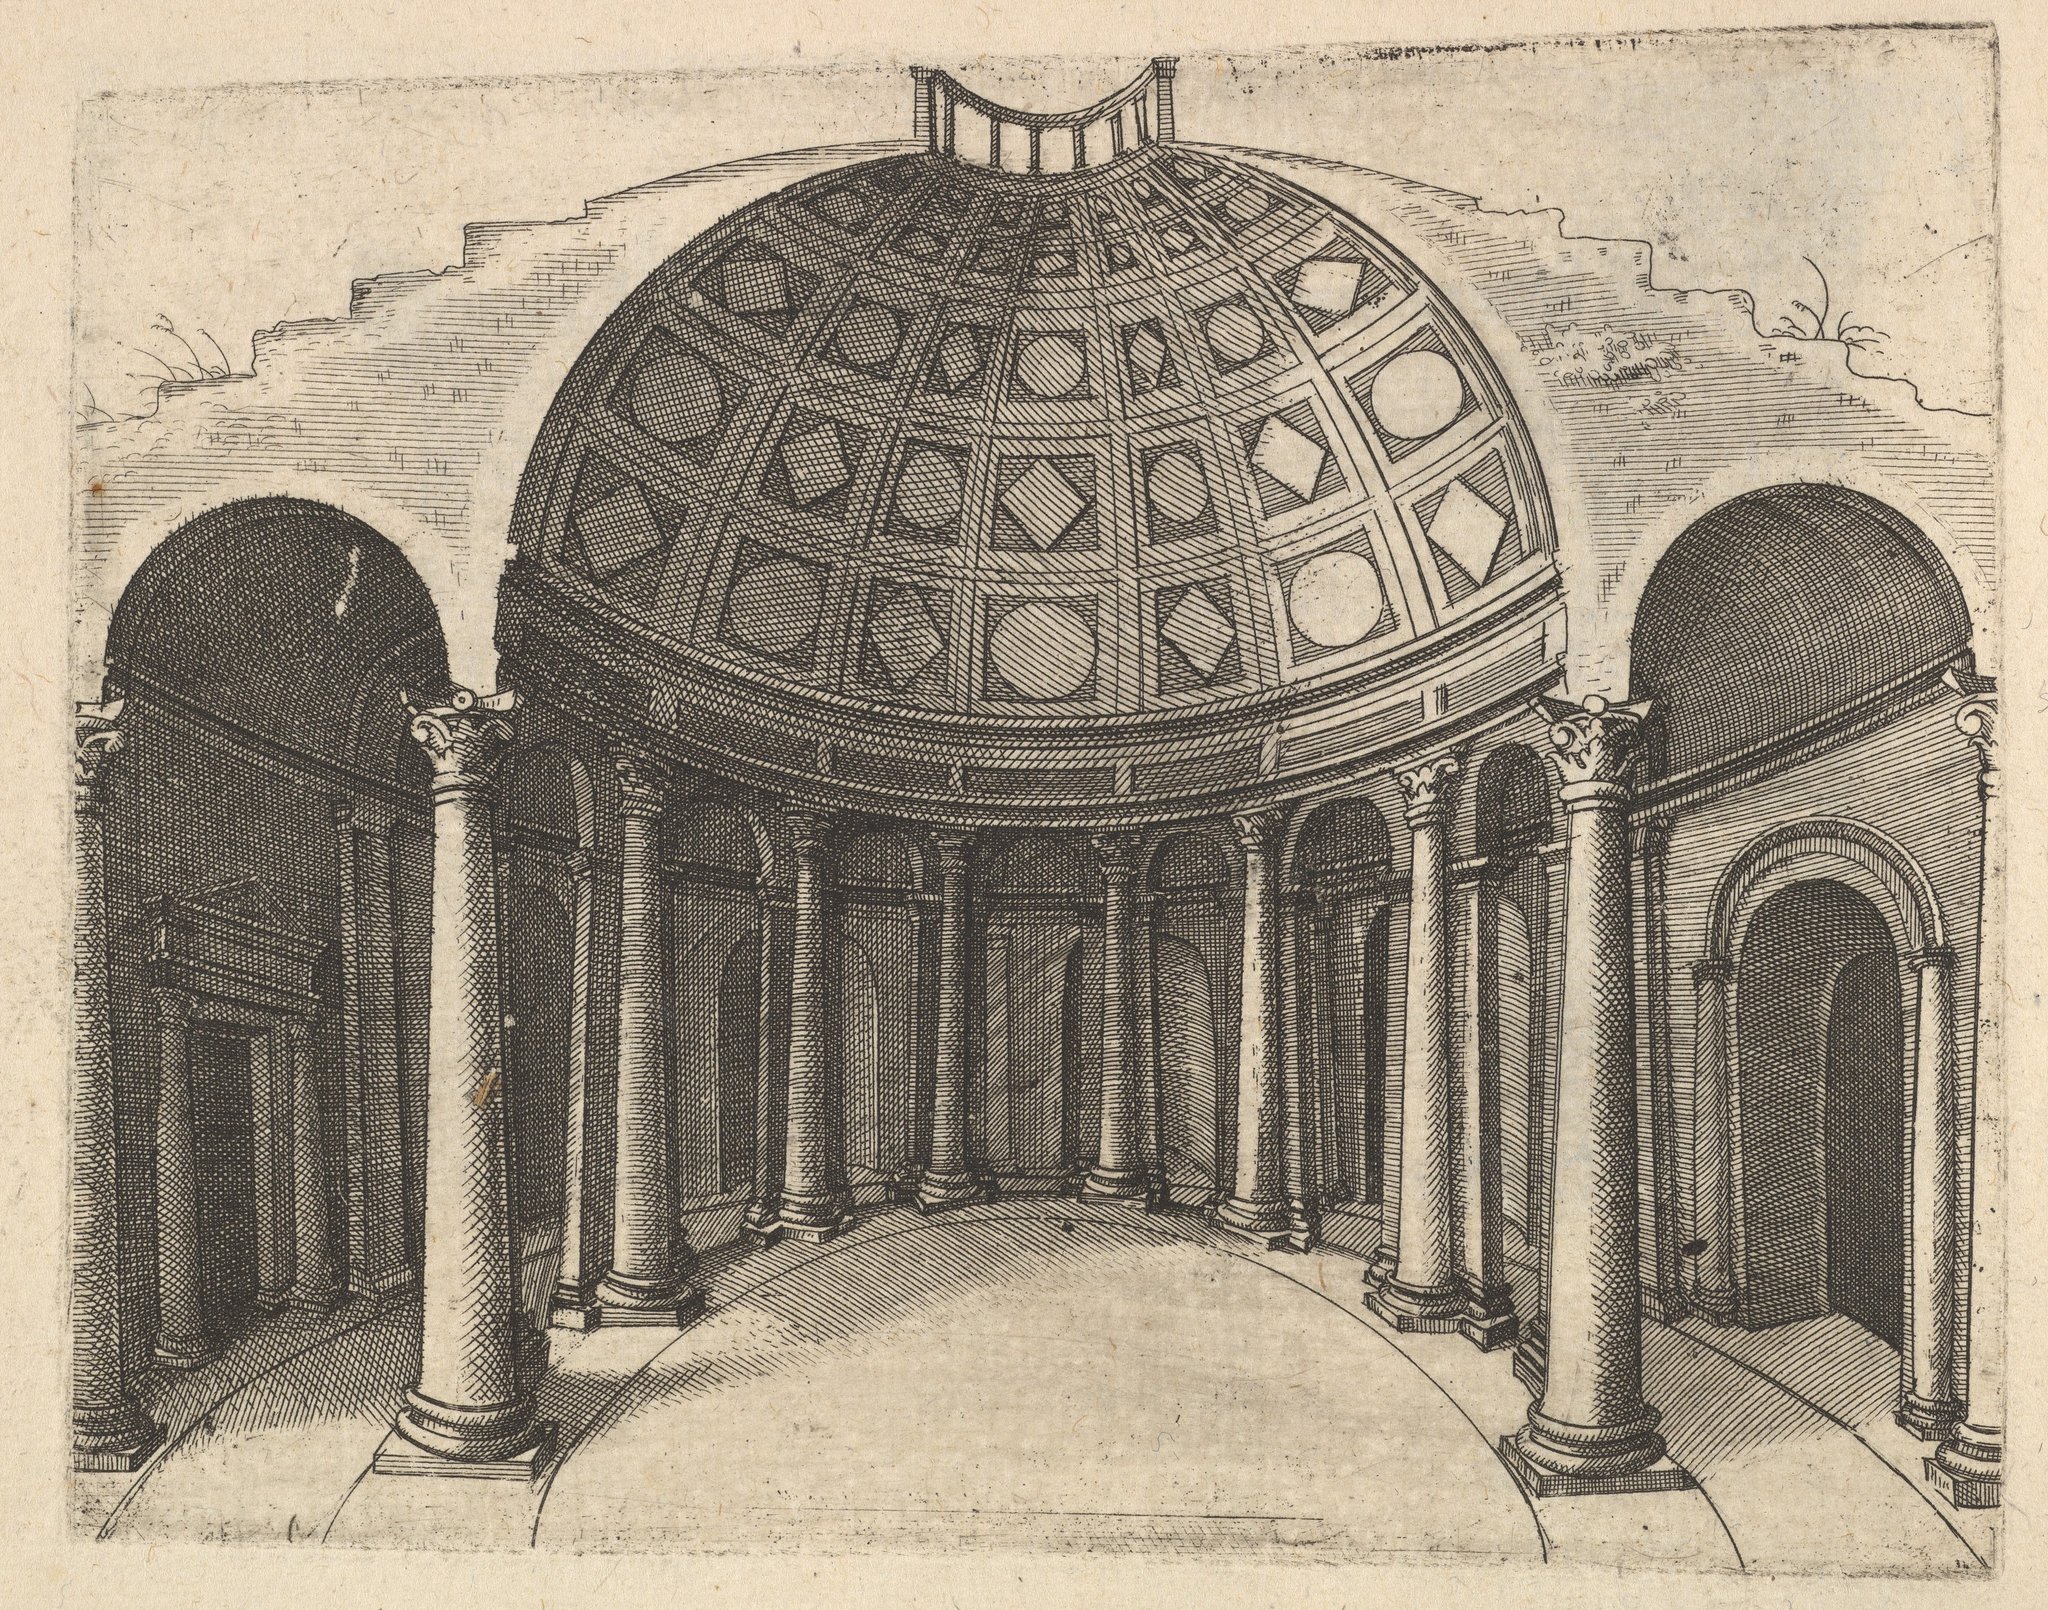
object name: book print ornament architecture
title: Cross-Section of Round Temple [Pinaculu Termar], from the series 'Ruinarum variarum fabricarum delineationes pictoribus caeterisque id genus artificibus multum utiles'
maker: lambert suavius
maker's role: artist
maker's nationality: netherlandish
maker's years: 1510-1576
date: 1554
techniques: etching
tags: architecture,columns